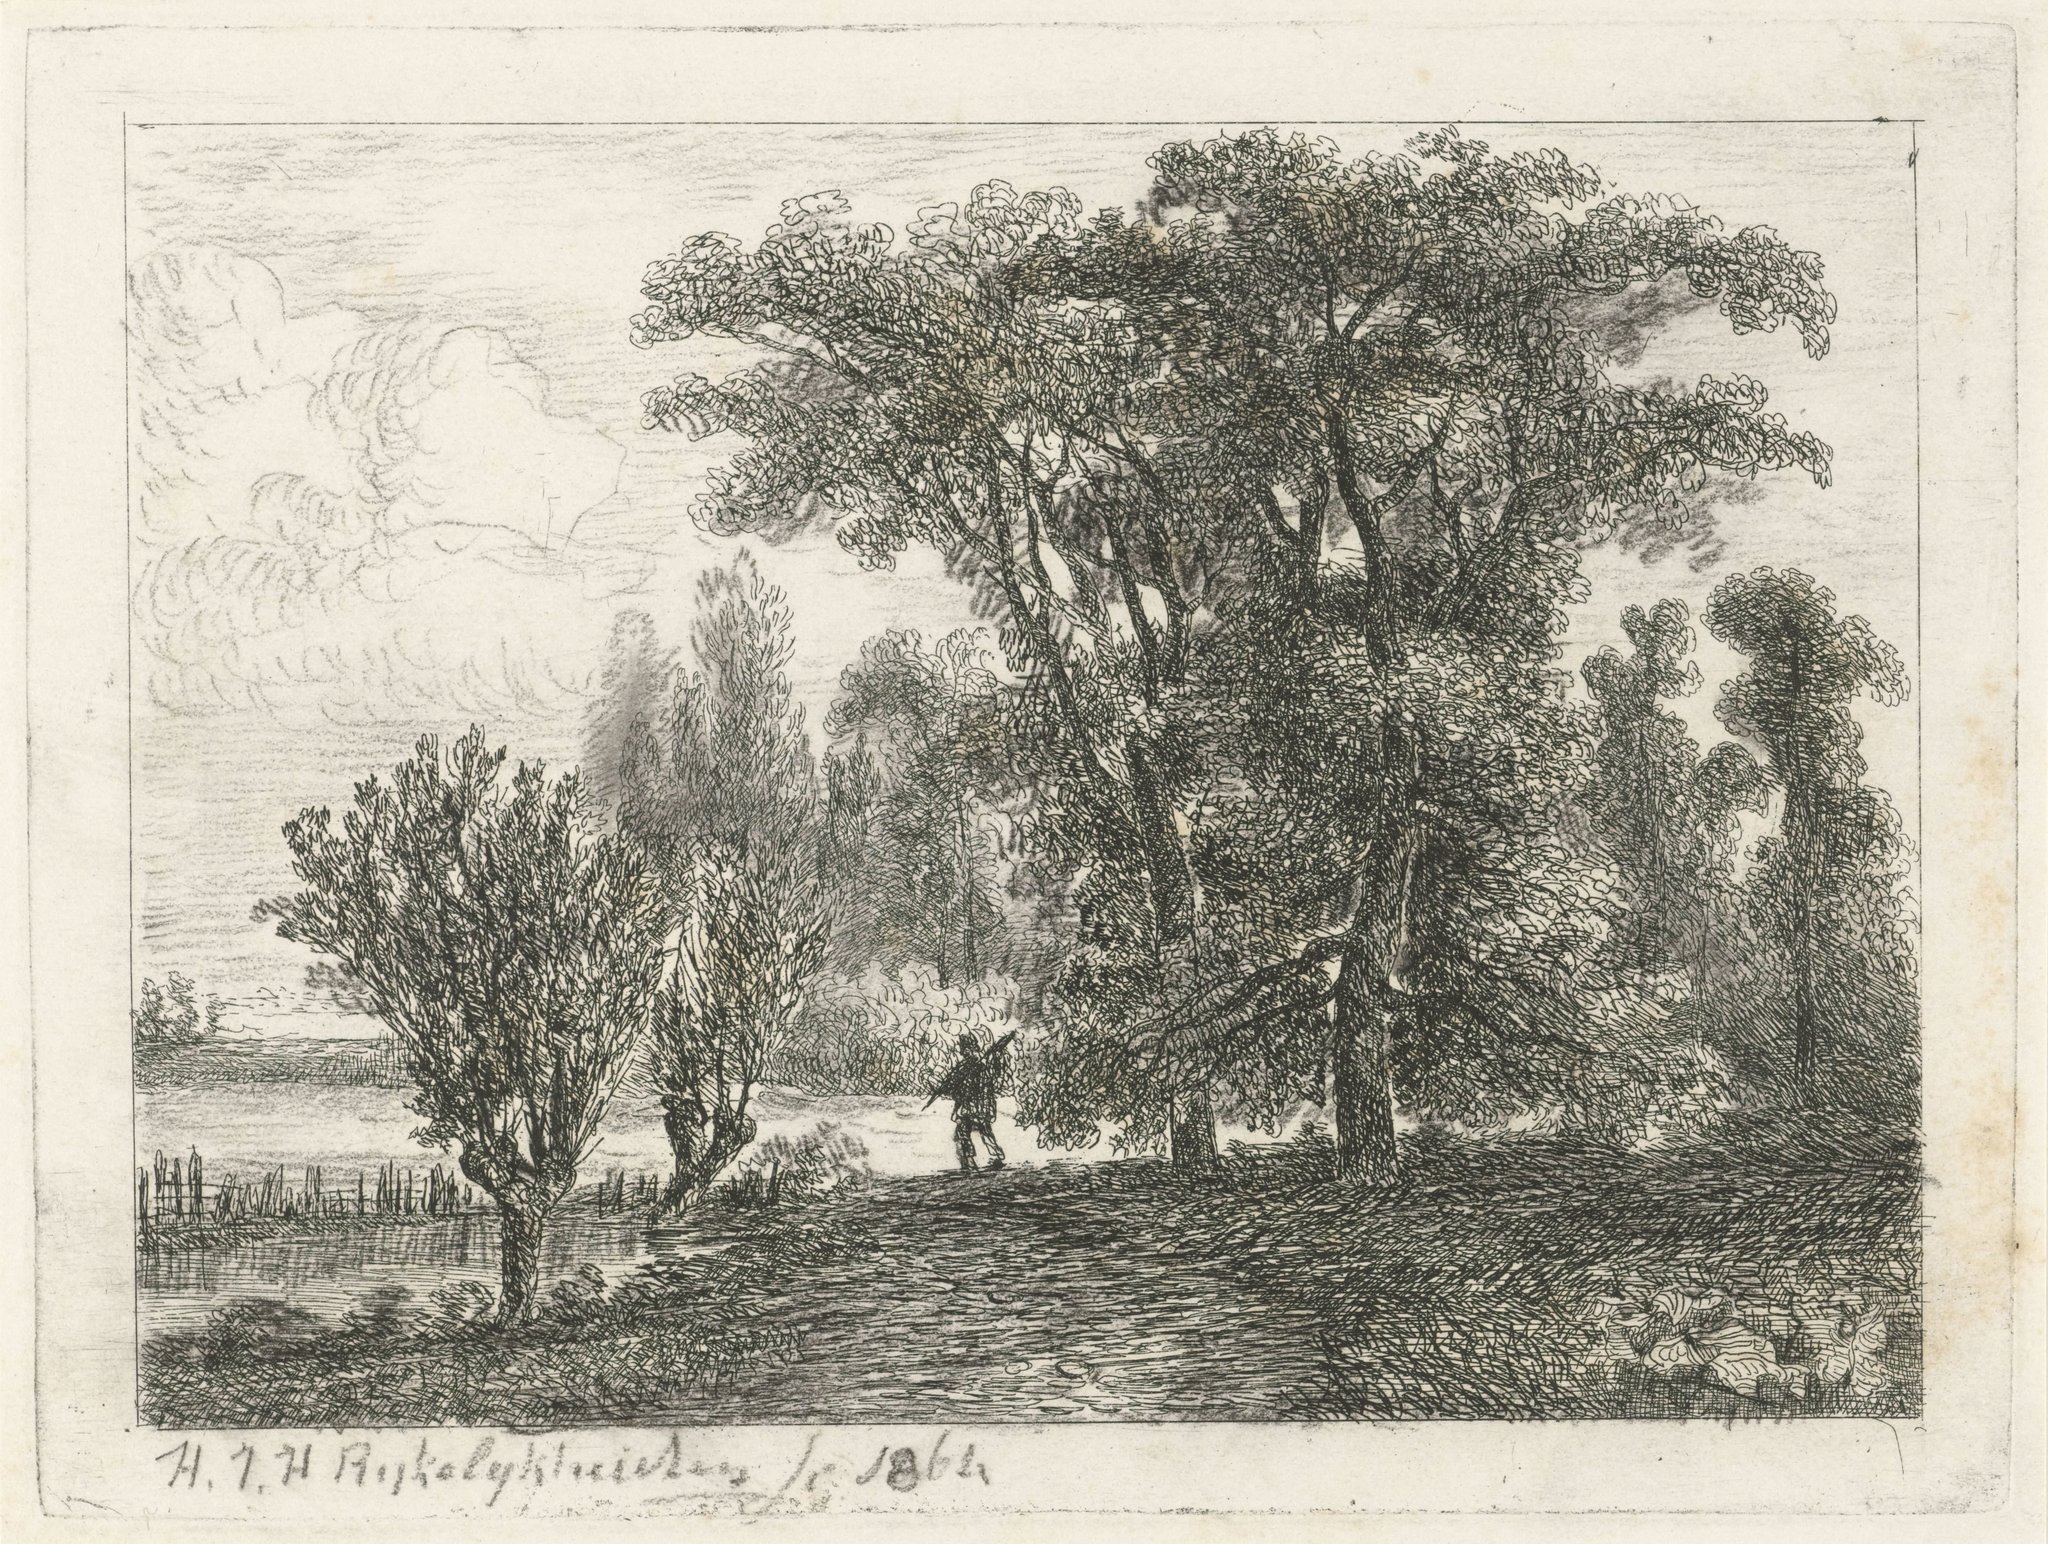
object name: print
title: Jager bij een bosrand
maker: hermanus jan hendrik van rijkelijkhuysen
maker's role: painter, print maker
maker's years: 1813-1883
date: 1864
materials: chalk, paper, pencil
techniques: etching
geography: utrecht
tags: hunter, forest, wood, pond, pool, trees: willow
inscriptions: inscription: ‘H.J.H. Rijkelijkhuysen [...] 1864’, collector's mark: Lugt 2228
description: Gezicht op de rand van een bos en een meertje, waar twee knotwilgen naast staan. Over een bospad loopt een jager.